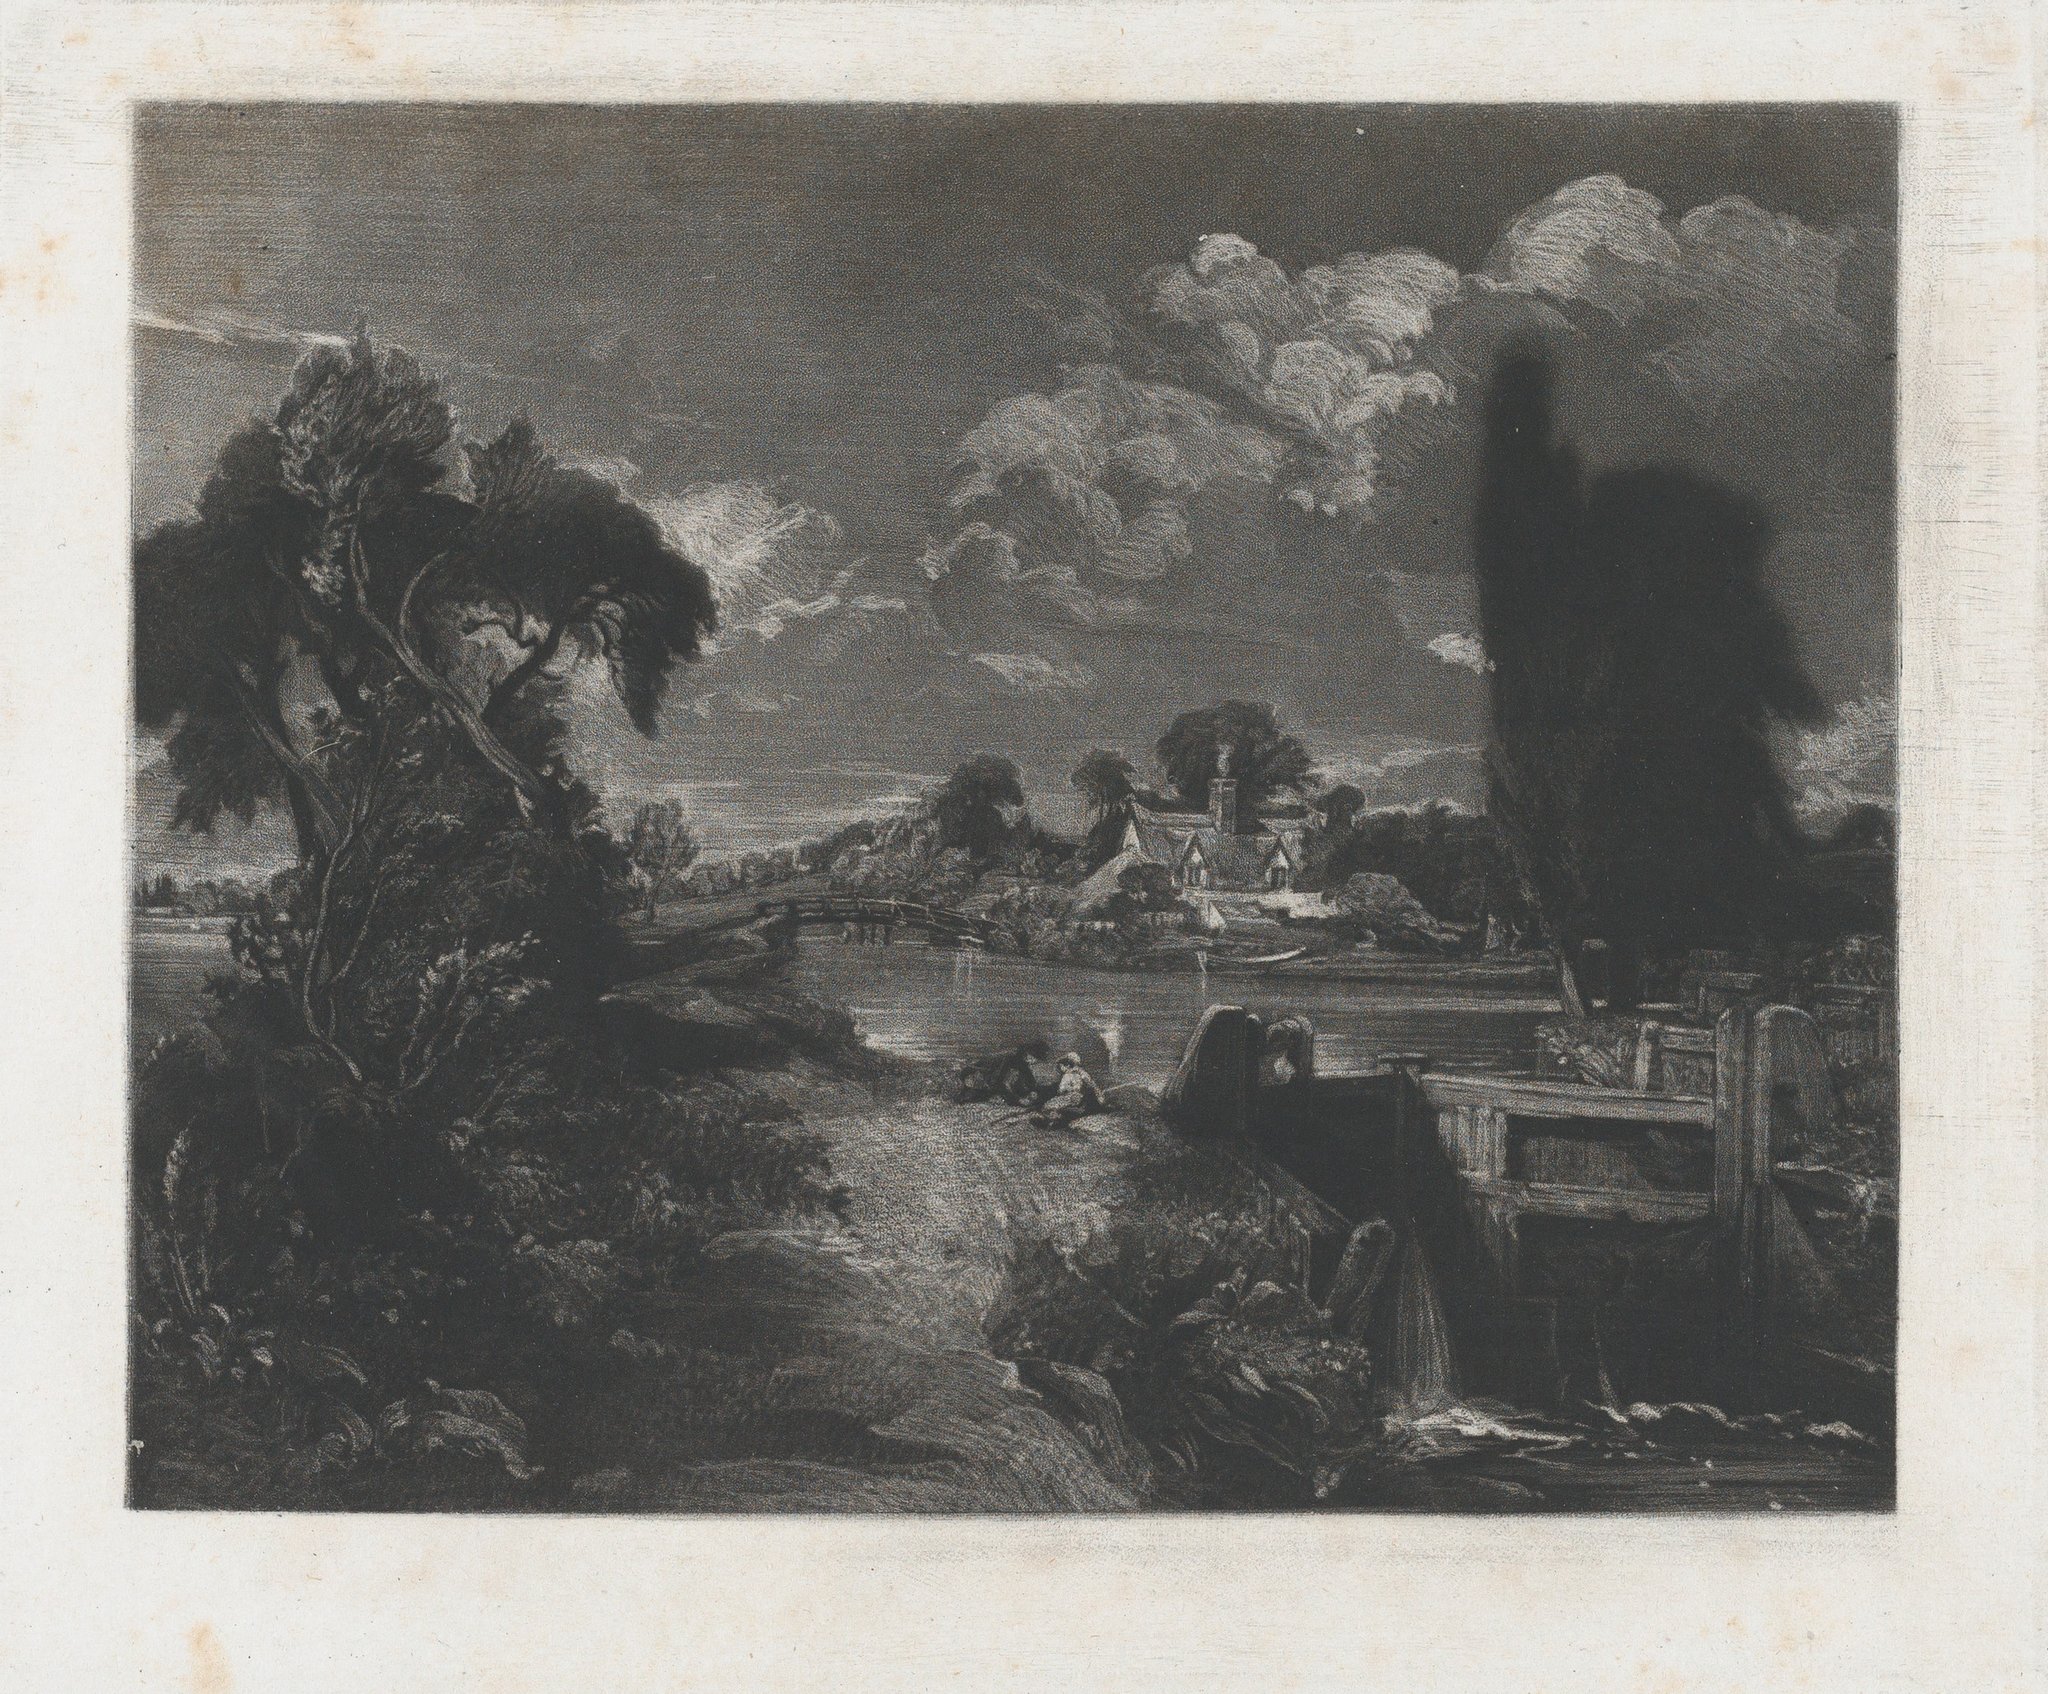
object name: print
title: A Lock on the Stour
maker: david lucas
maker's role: artist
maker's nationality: british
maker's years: 1802-1881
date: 1830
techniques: mezzotint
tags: rivers,landscapes